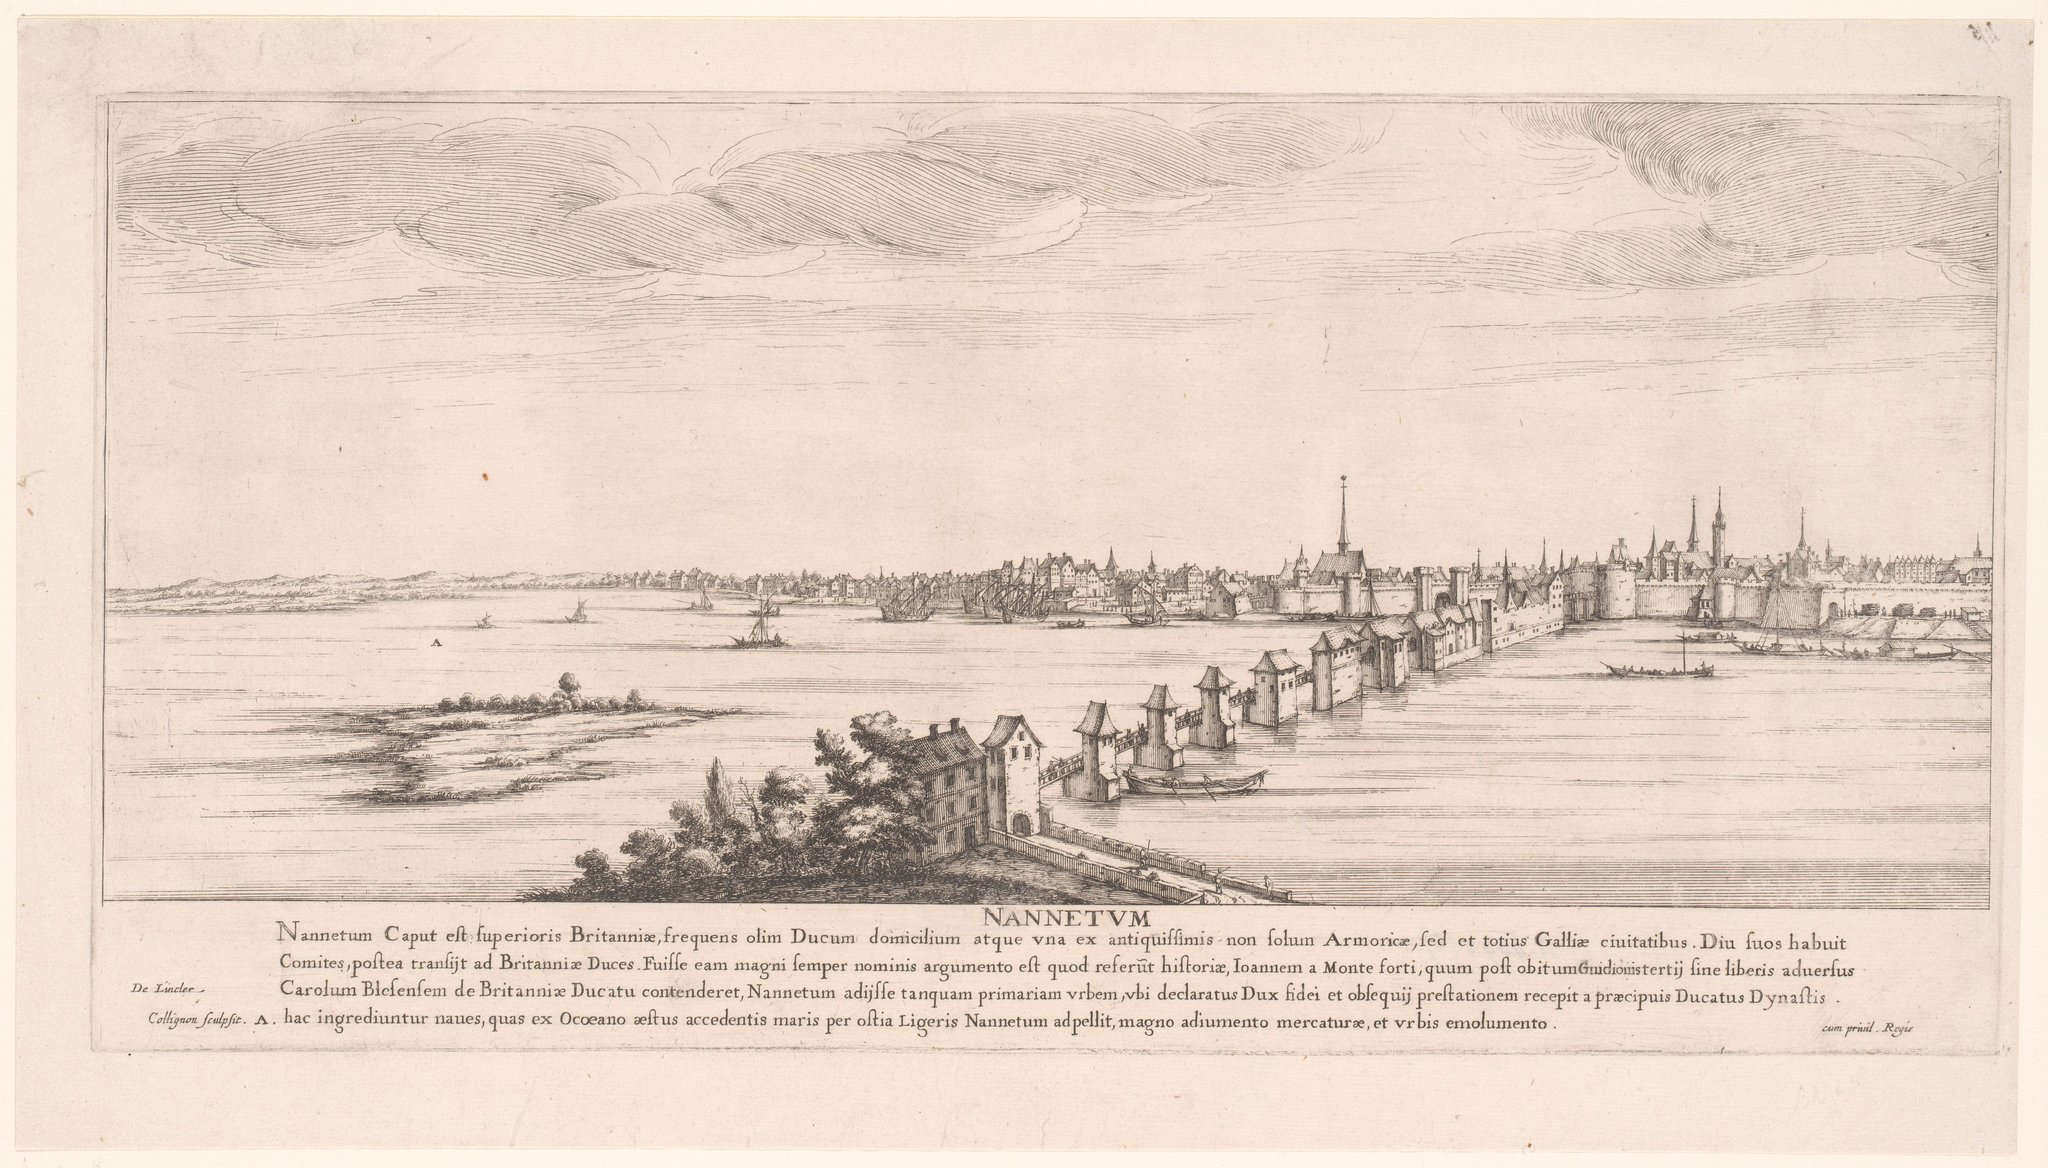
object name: print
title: Riviergezichten in Frankrijk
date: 1620-1687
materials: paper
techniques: etching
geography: paris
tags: city-view in general; 'veduta', river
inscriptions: collector's mark: Lugt 2228, watermark